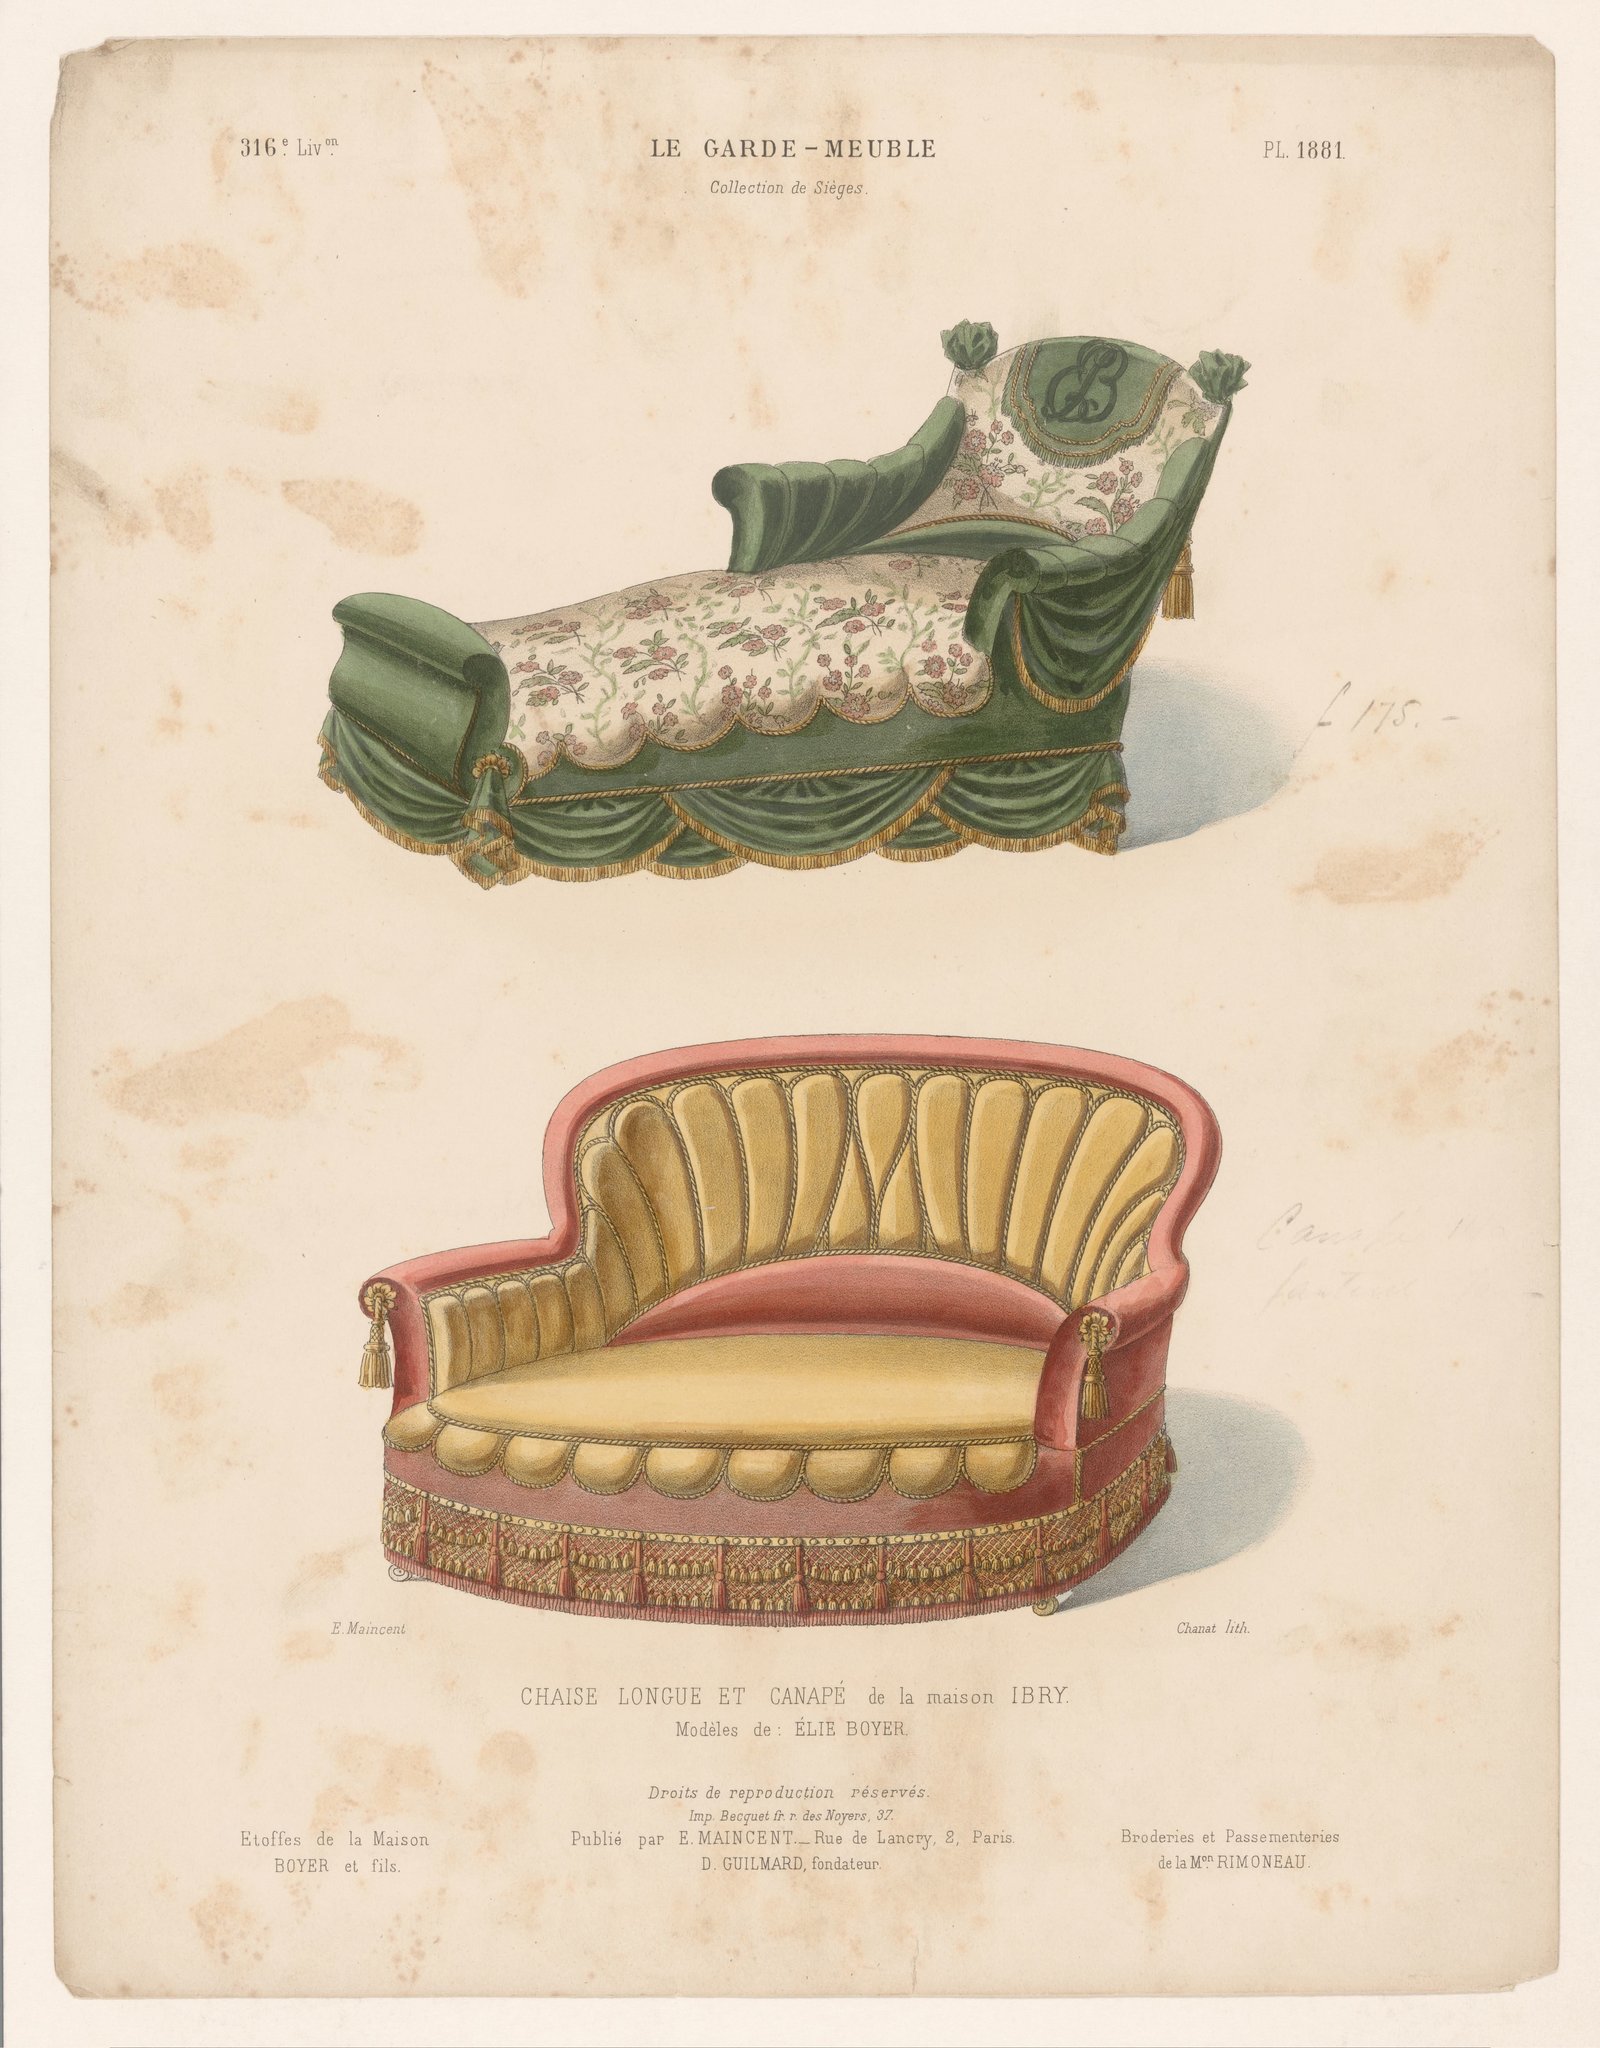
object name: print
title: Chaise longue en canapé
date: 1885-1895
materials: paper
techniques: hand coloring, lithograph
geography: paris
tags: seating furniture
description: Ieder Livraison in de serie Le Garde-Meuble bevat negen platen: drie 'sièges' (zitmeubels), drie 'meubles' (diverse meubels zoals tafels en kasten) en drie 'tentures' (gordijnen en draperieën).